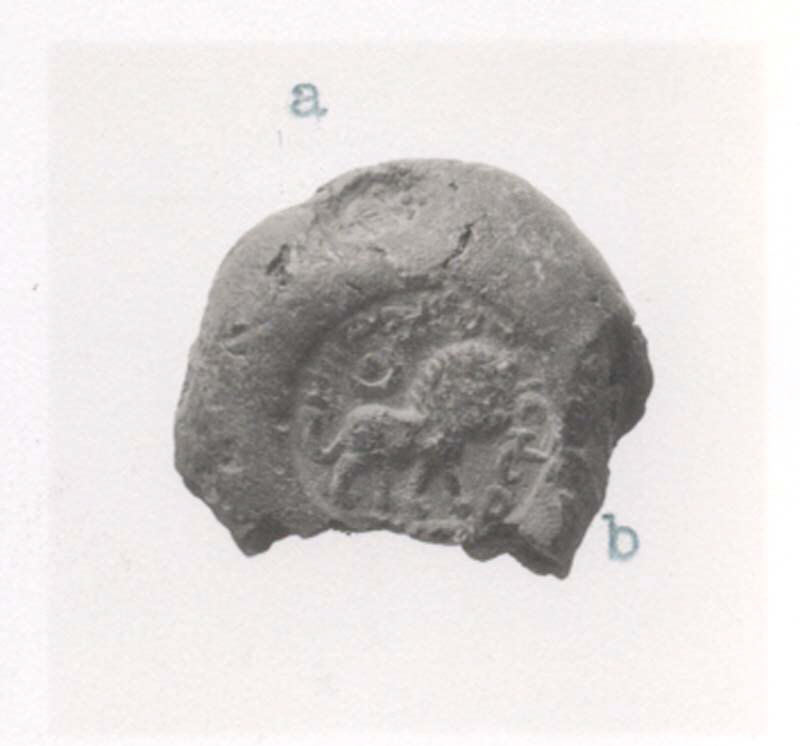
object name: sealing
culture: sasanian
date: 601-700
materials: clay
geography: iran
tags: lions